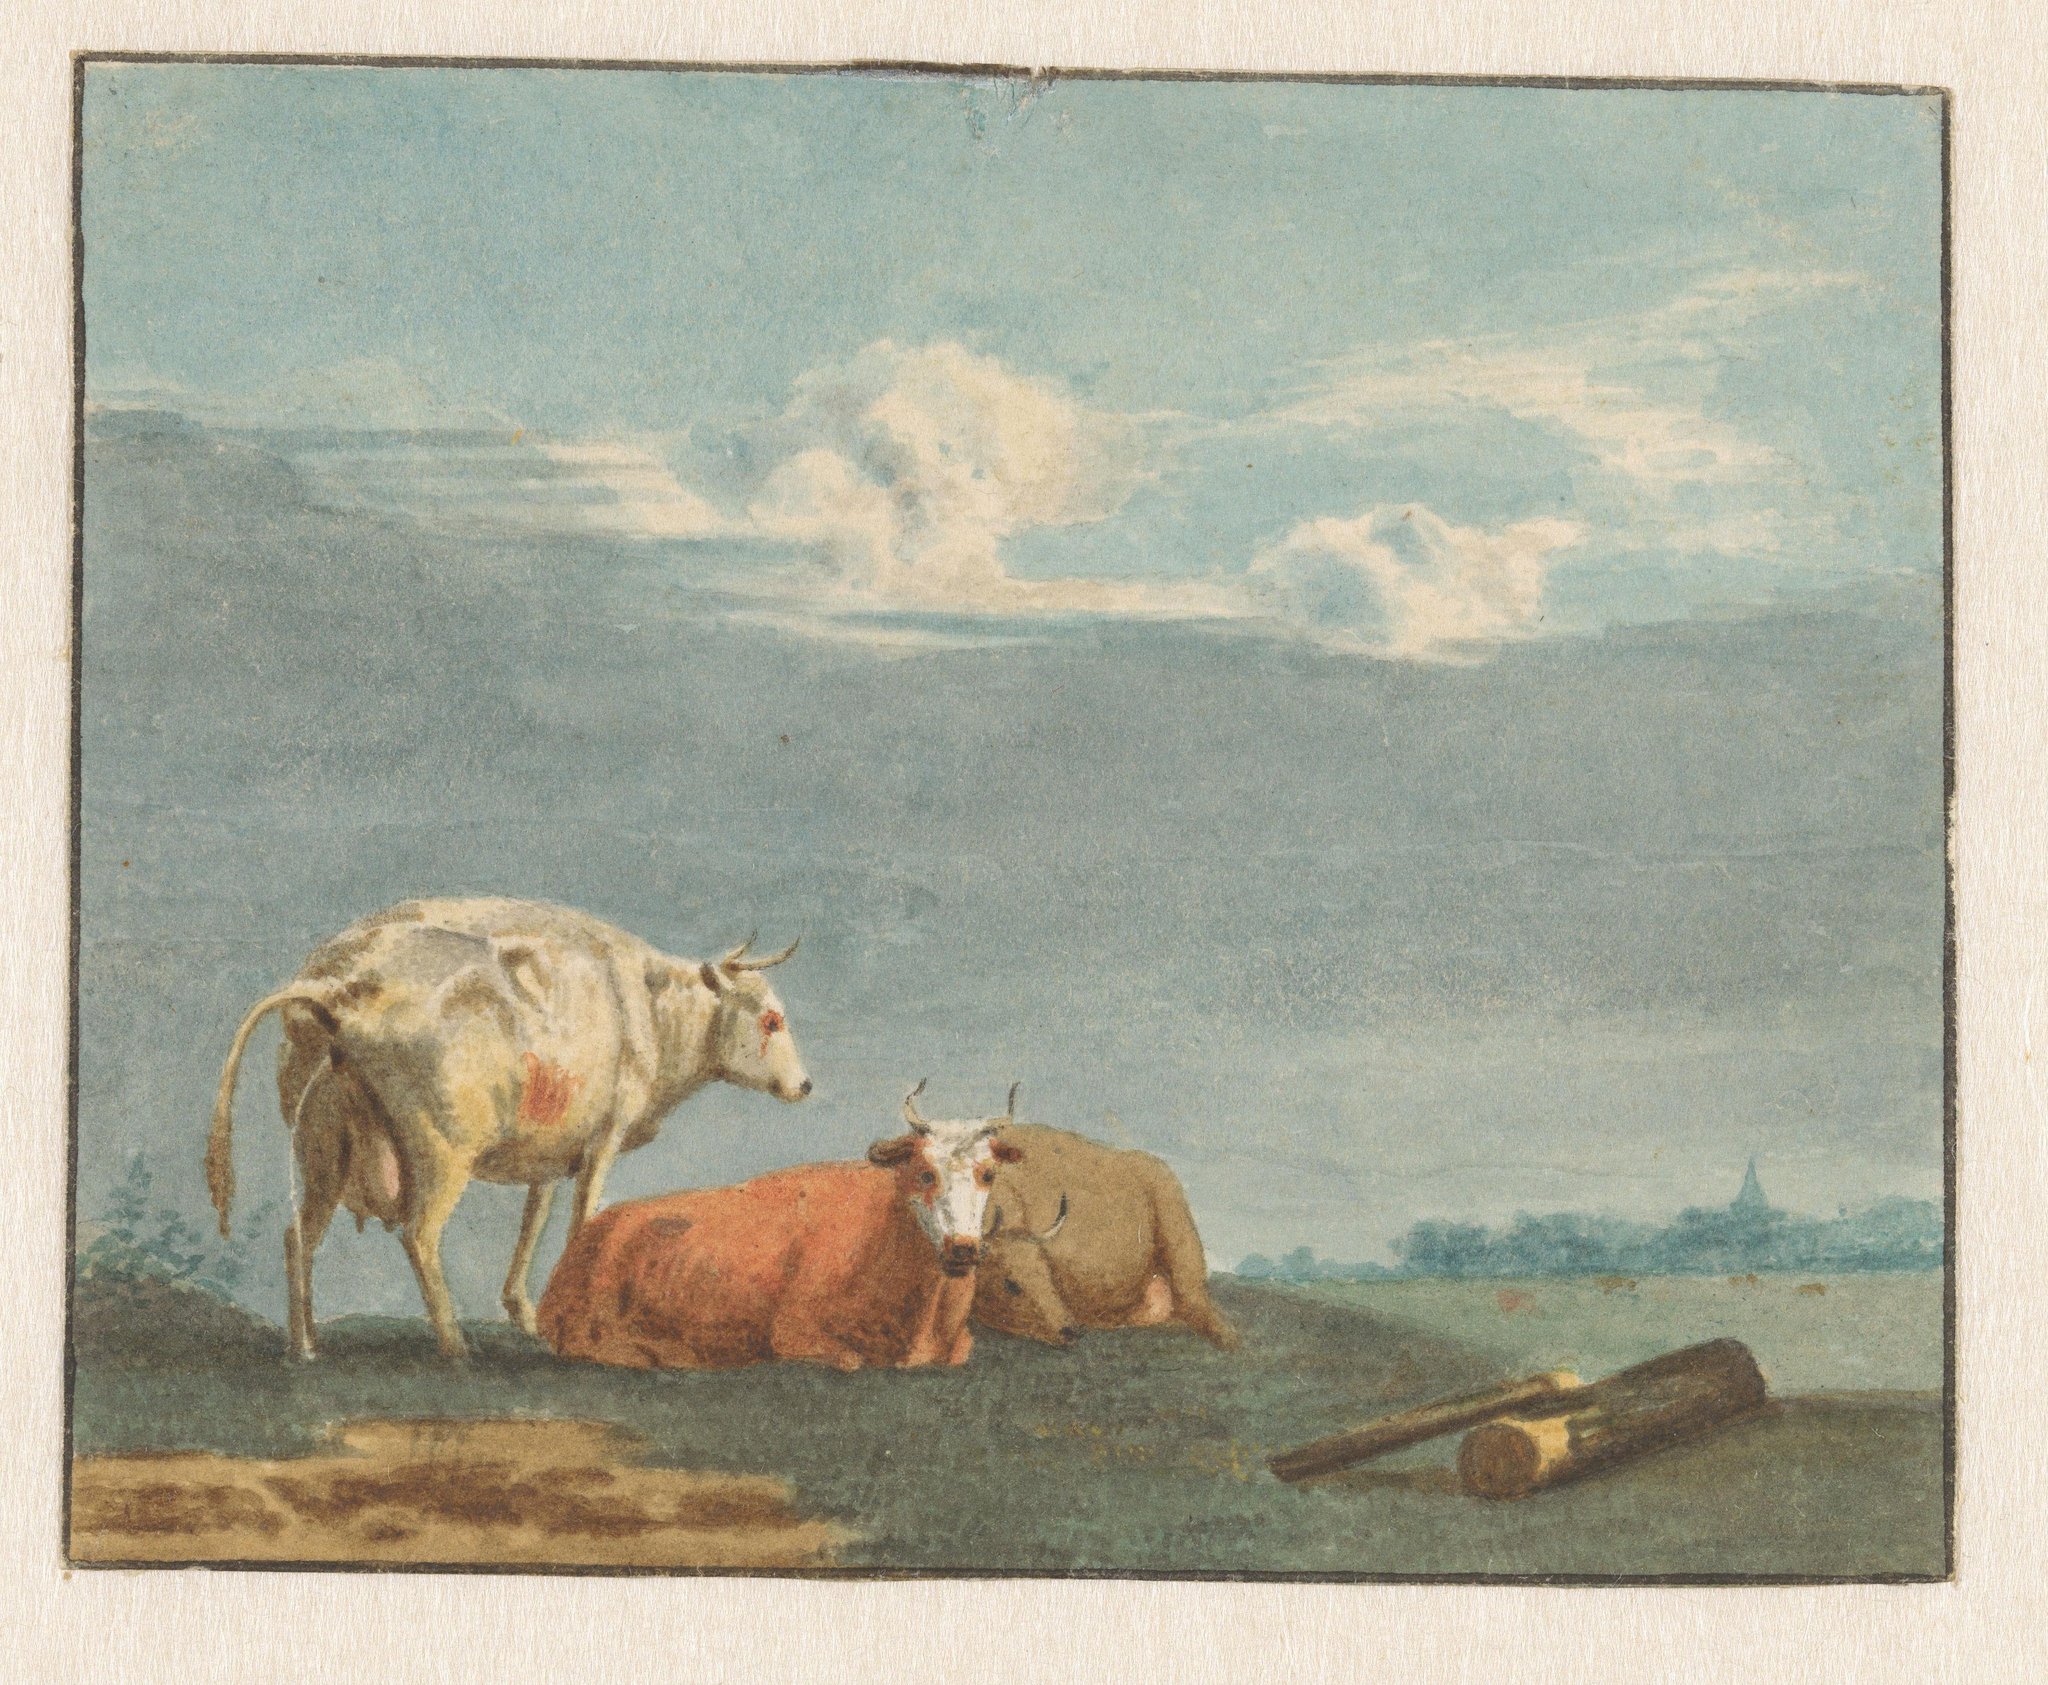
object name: drawing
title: Drie koeien in een wei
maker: Anonymous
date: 1800-1900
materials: paper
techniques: brush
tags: cow